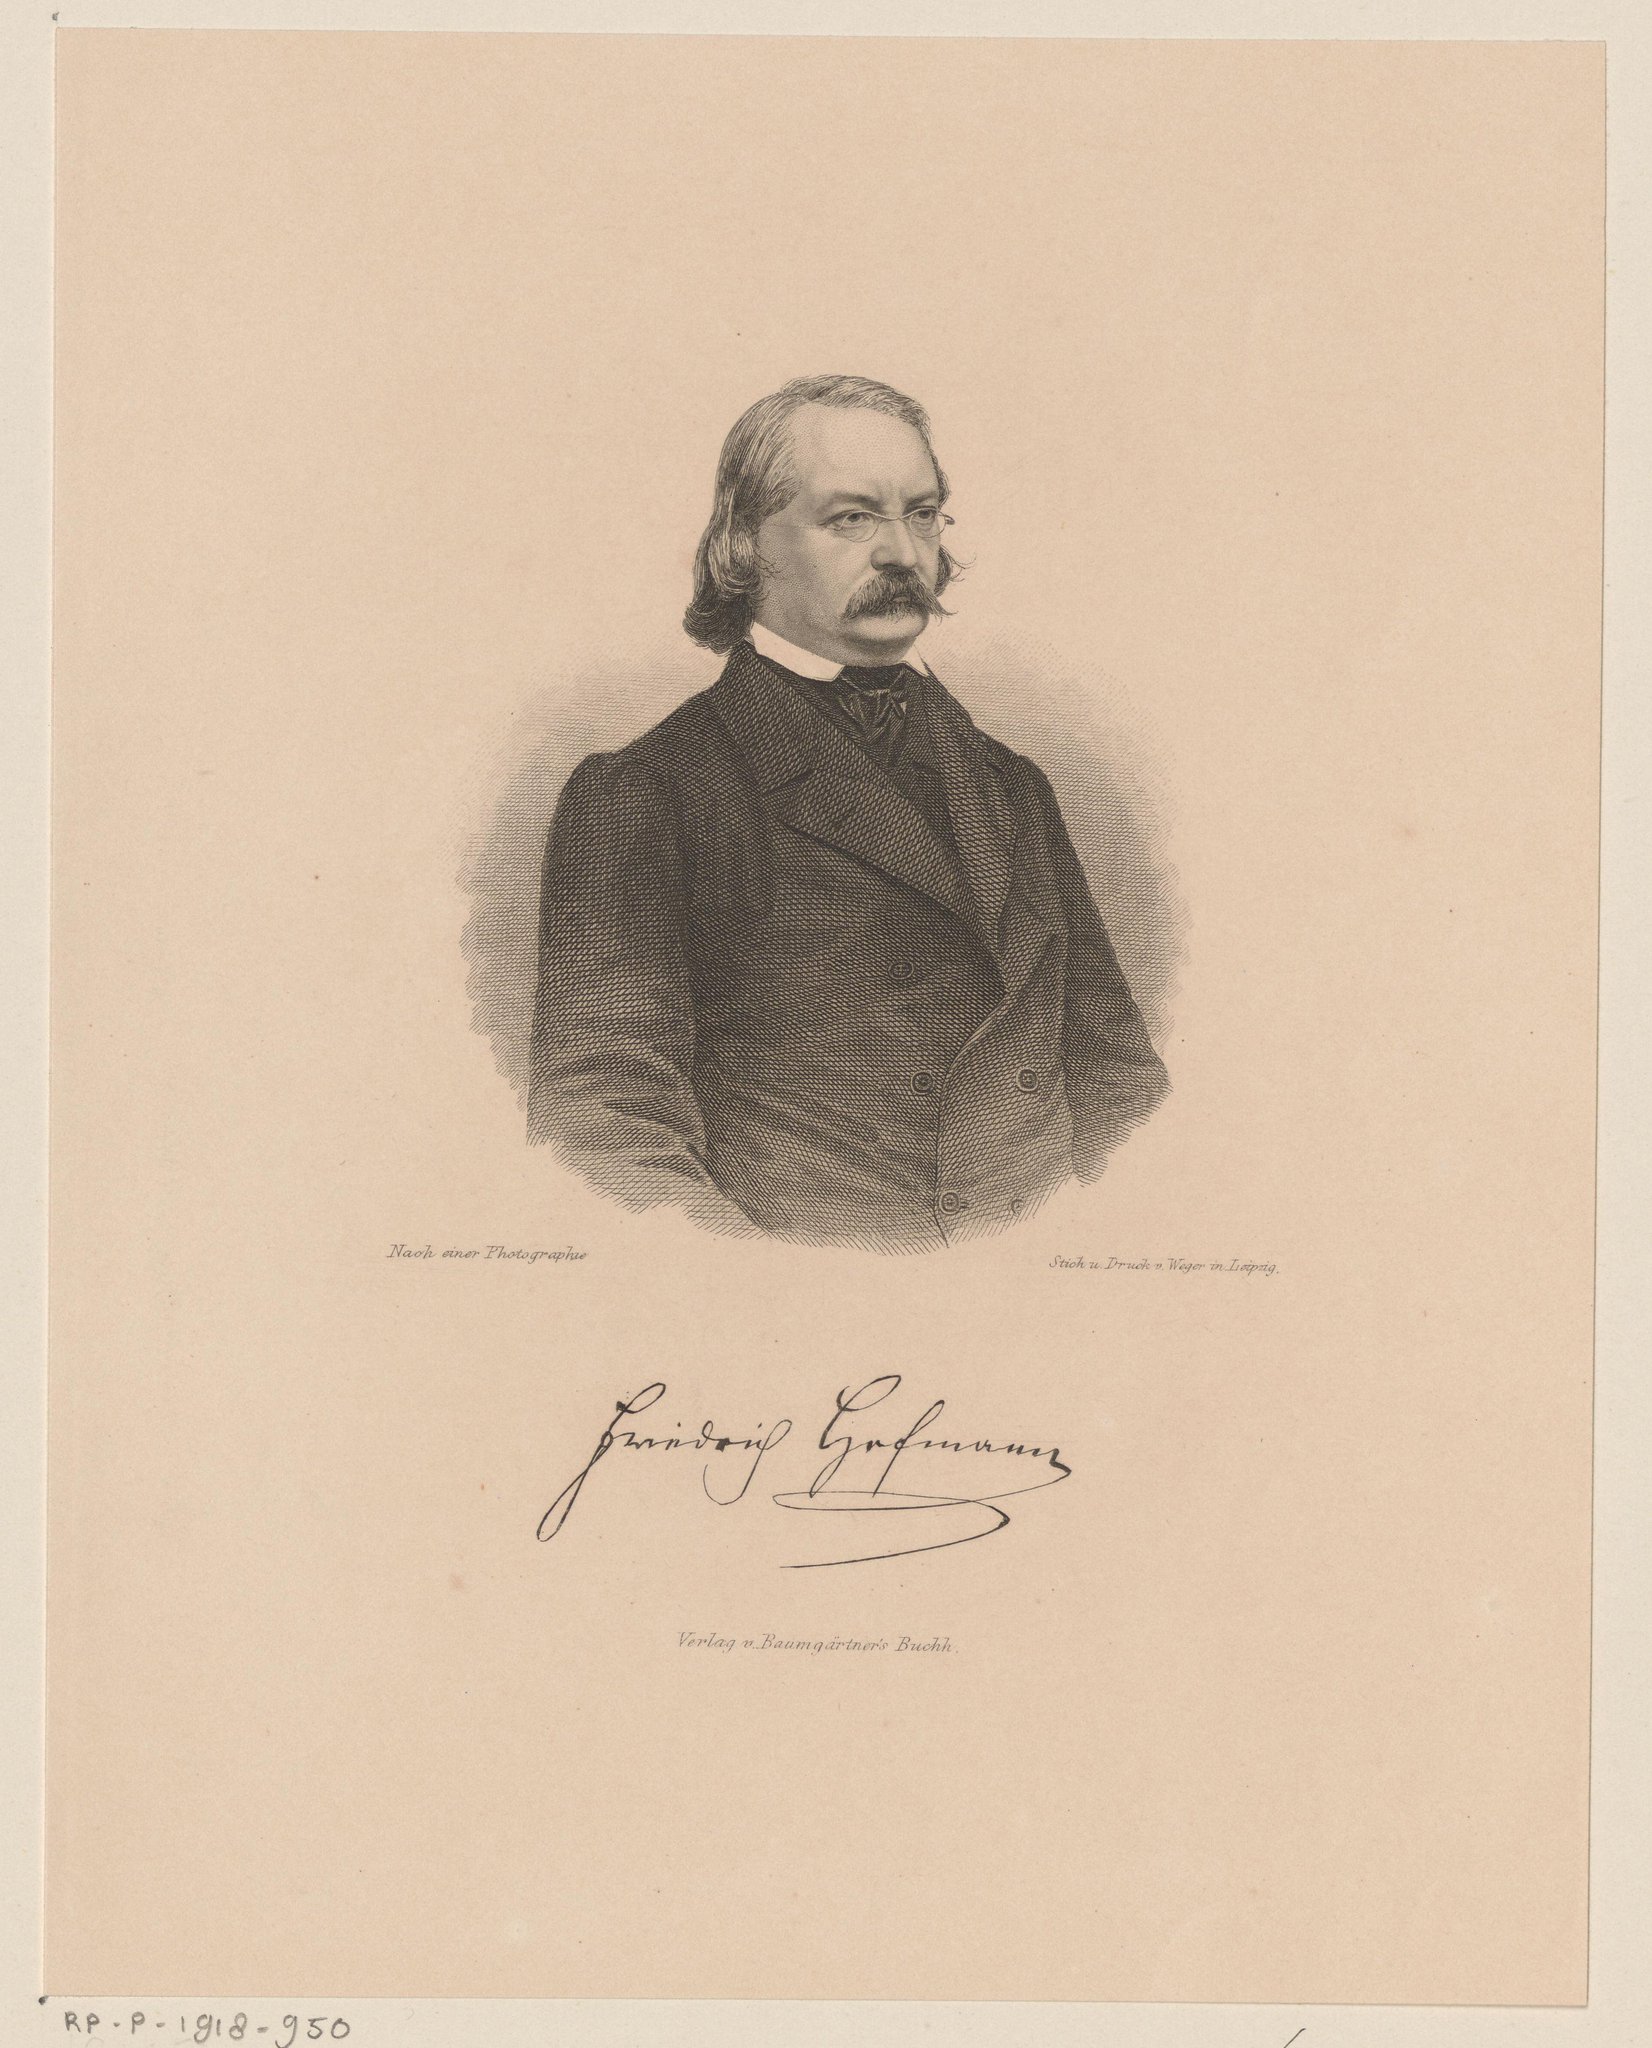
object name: print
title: Portret van Friedrich Hofmann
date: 1840-1892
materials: paper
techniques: engraving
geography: leipzig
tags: eyeglasses, spectacles, historical persons, writer, poet, author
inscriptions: collector's mark: Lugt 2233